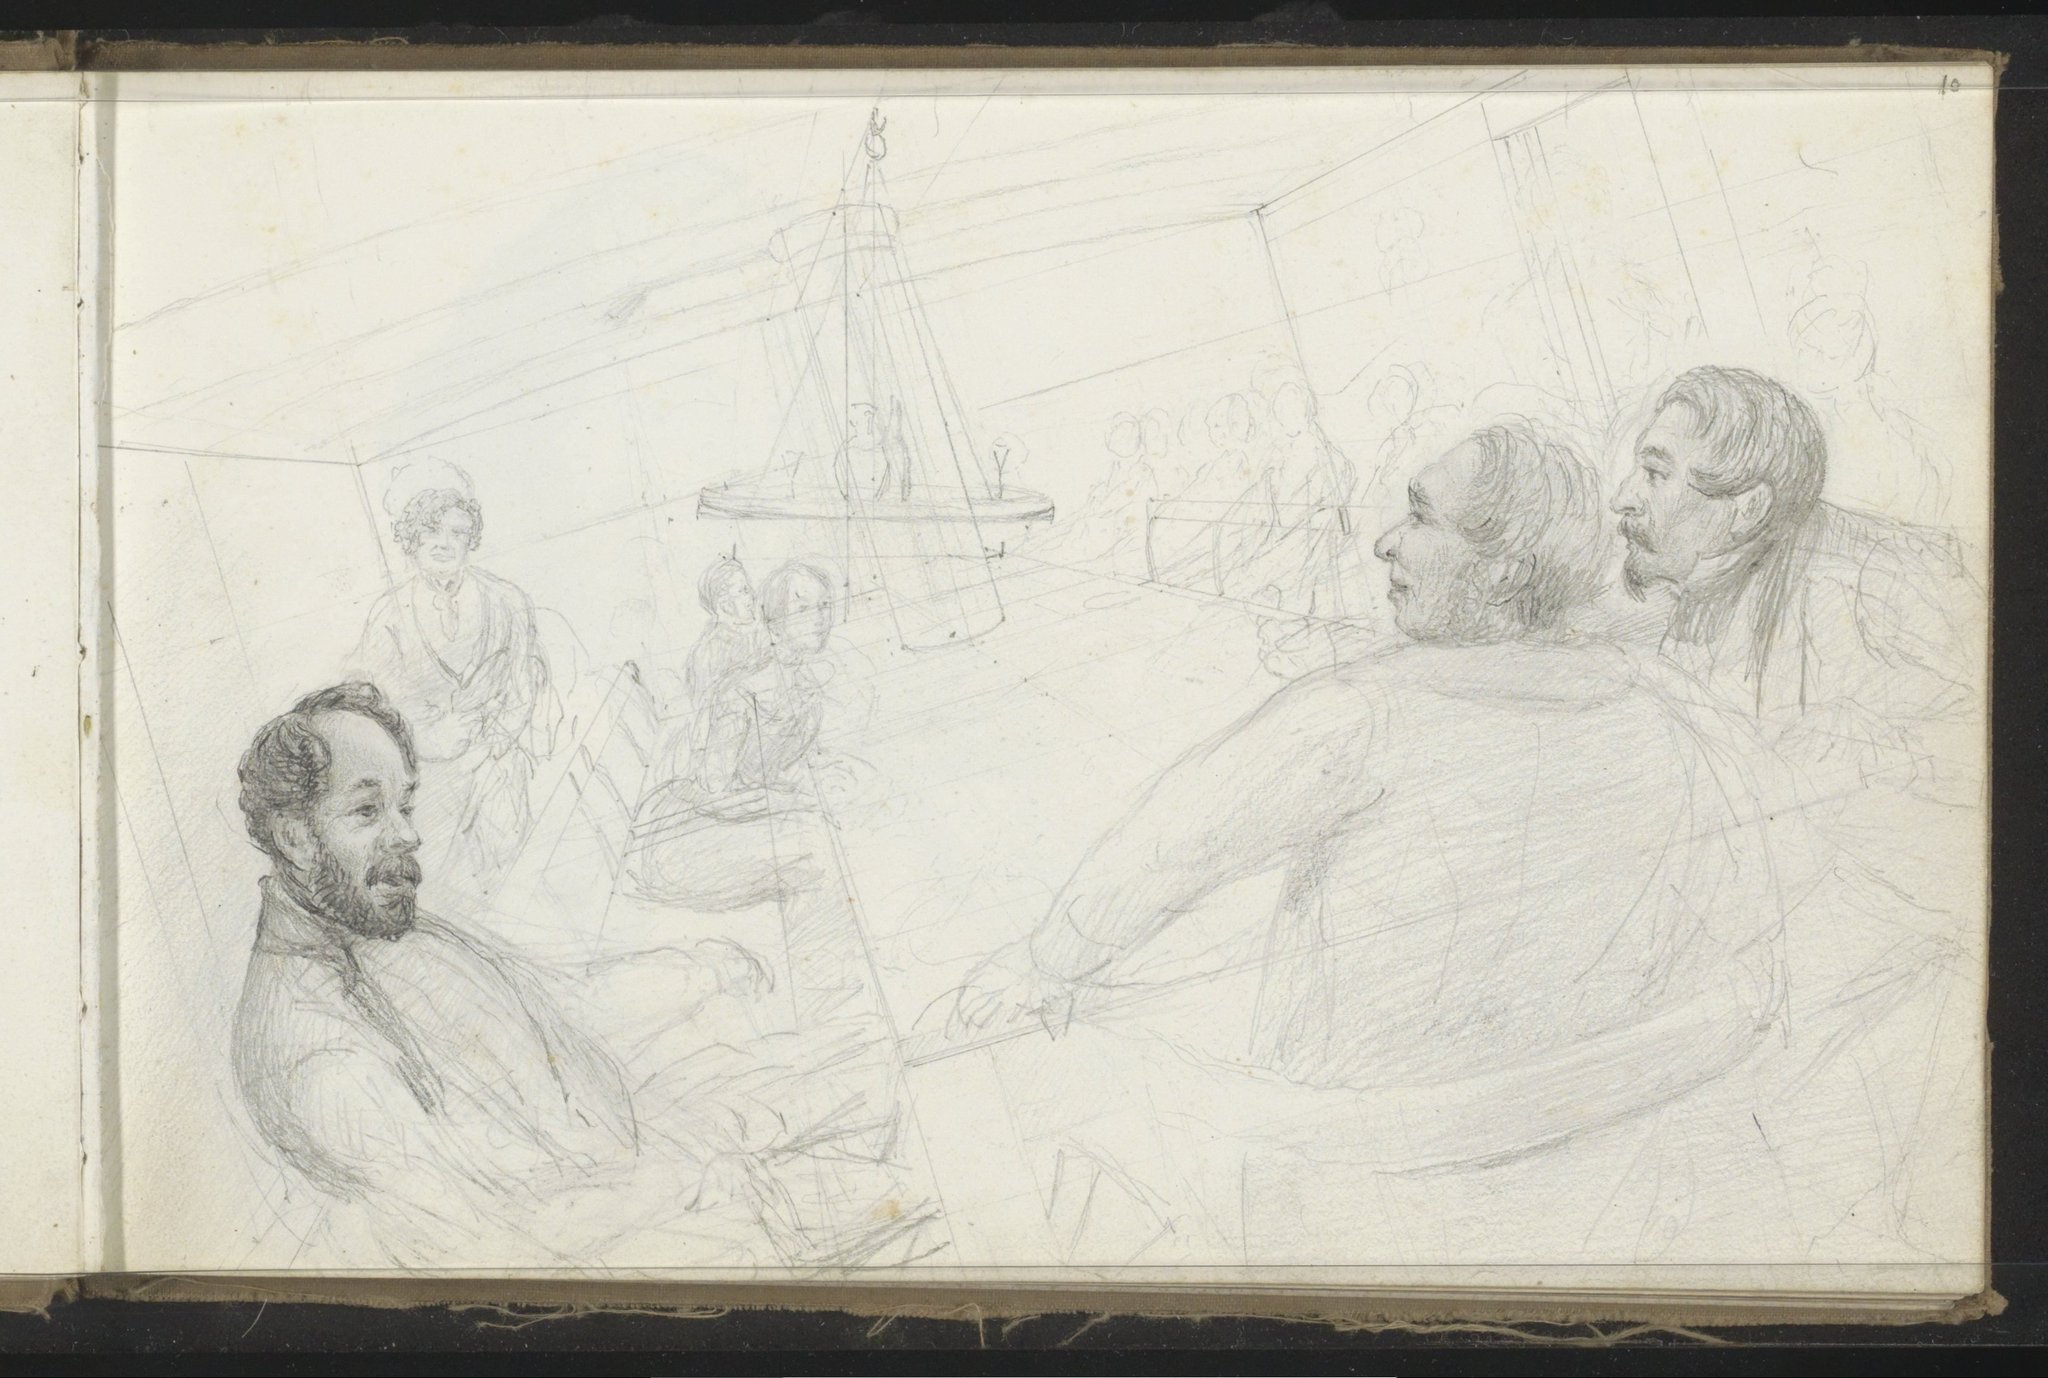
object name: sketchbook leaf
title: Figuren rond een tafel in een kajuit bij stormachtig weer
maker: christian heinrich gottlieb steuerwald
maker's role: draughtsman, print maker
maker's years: 1802-1874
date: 1848-1854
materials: paper, pencil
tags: parts of ship's interior (cabin), storm at sea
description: Blad 10 recto uit een schetsboek met 58 bladen.